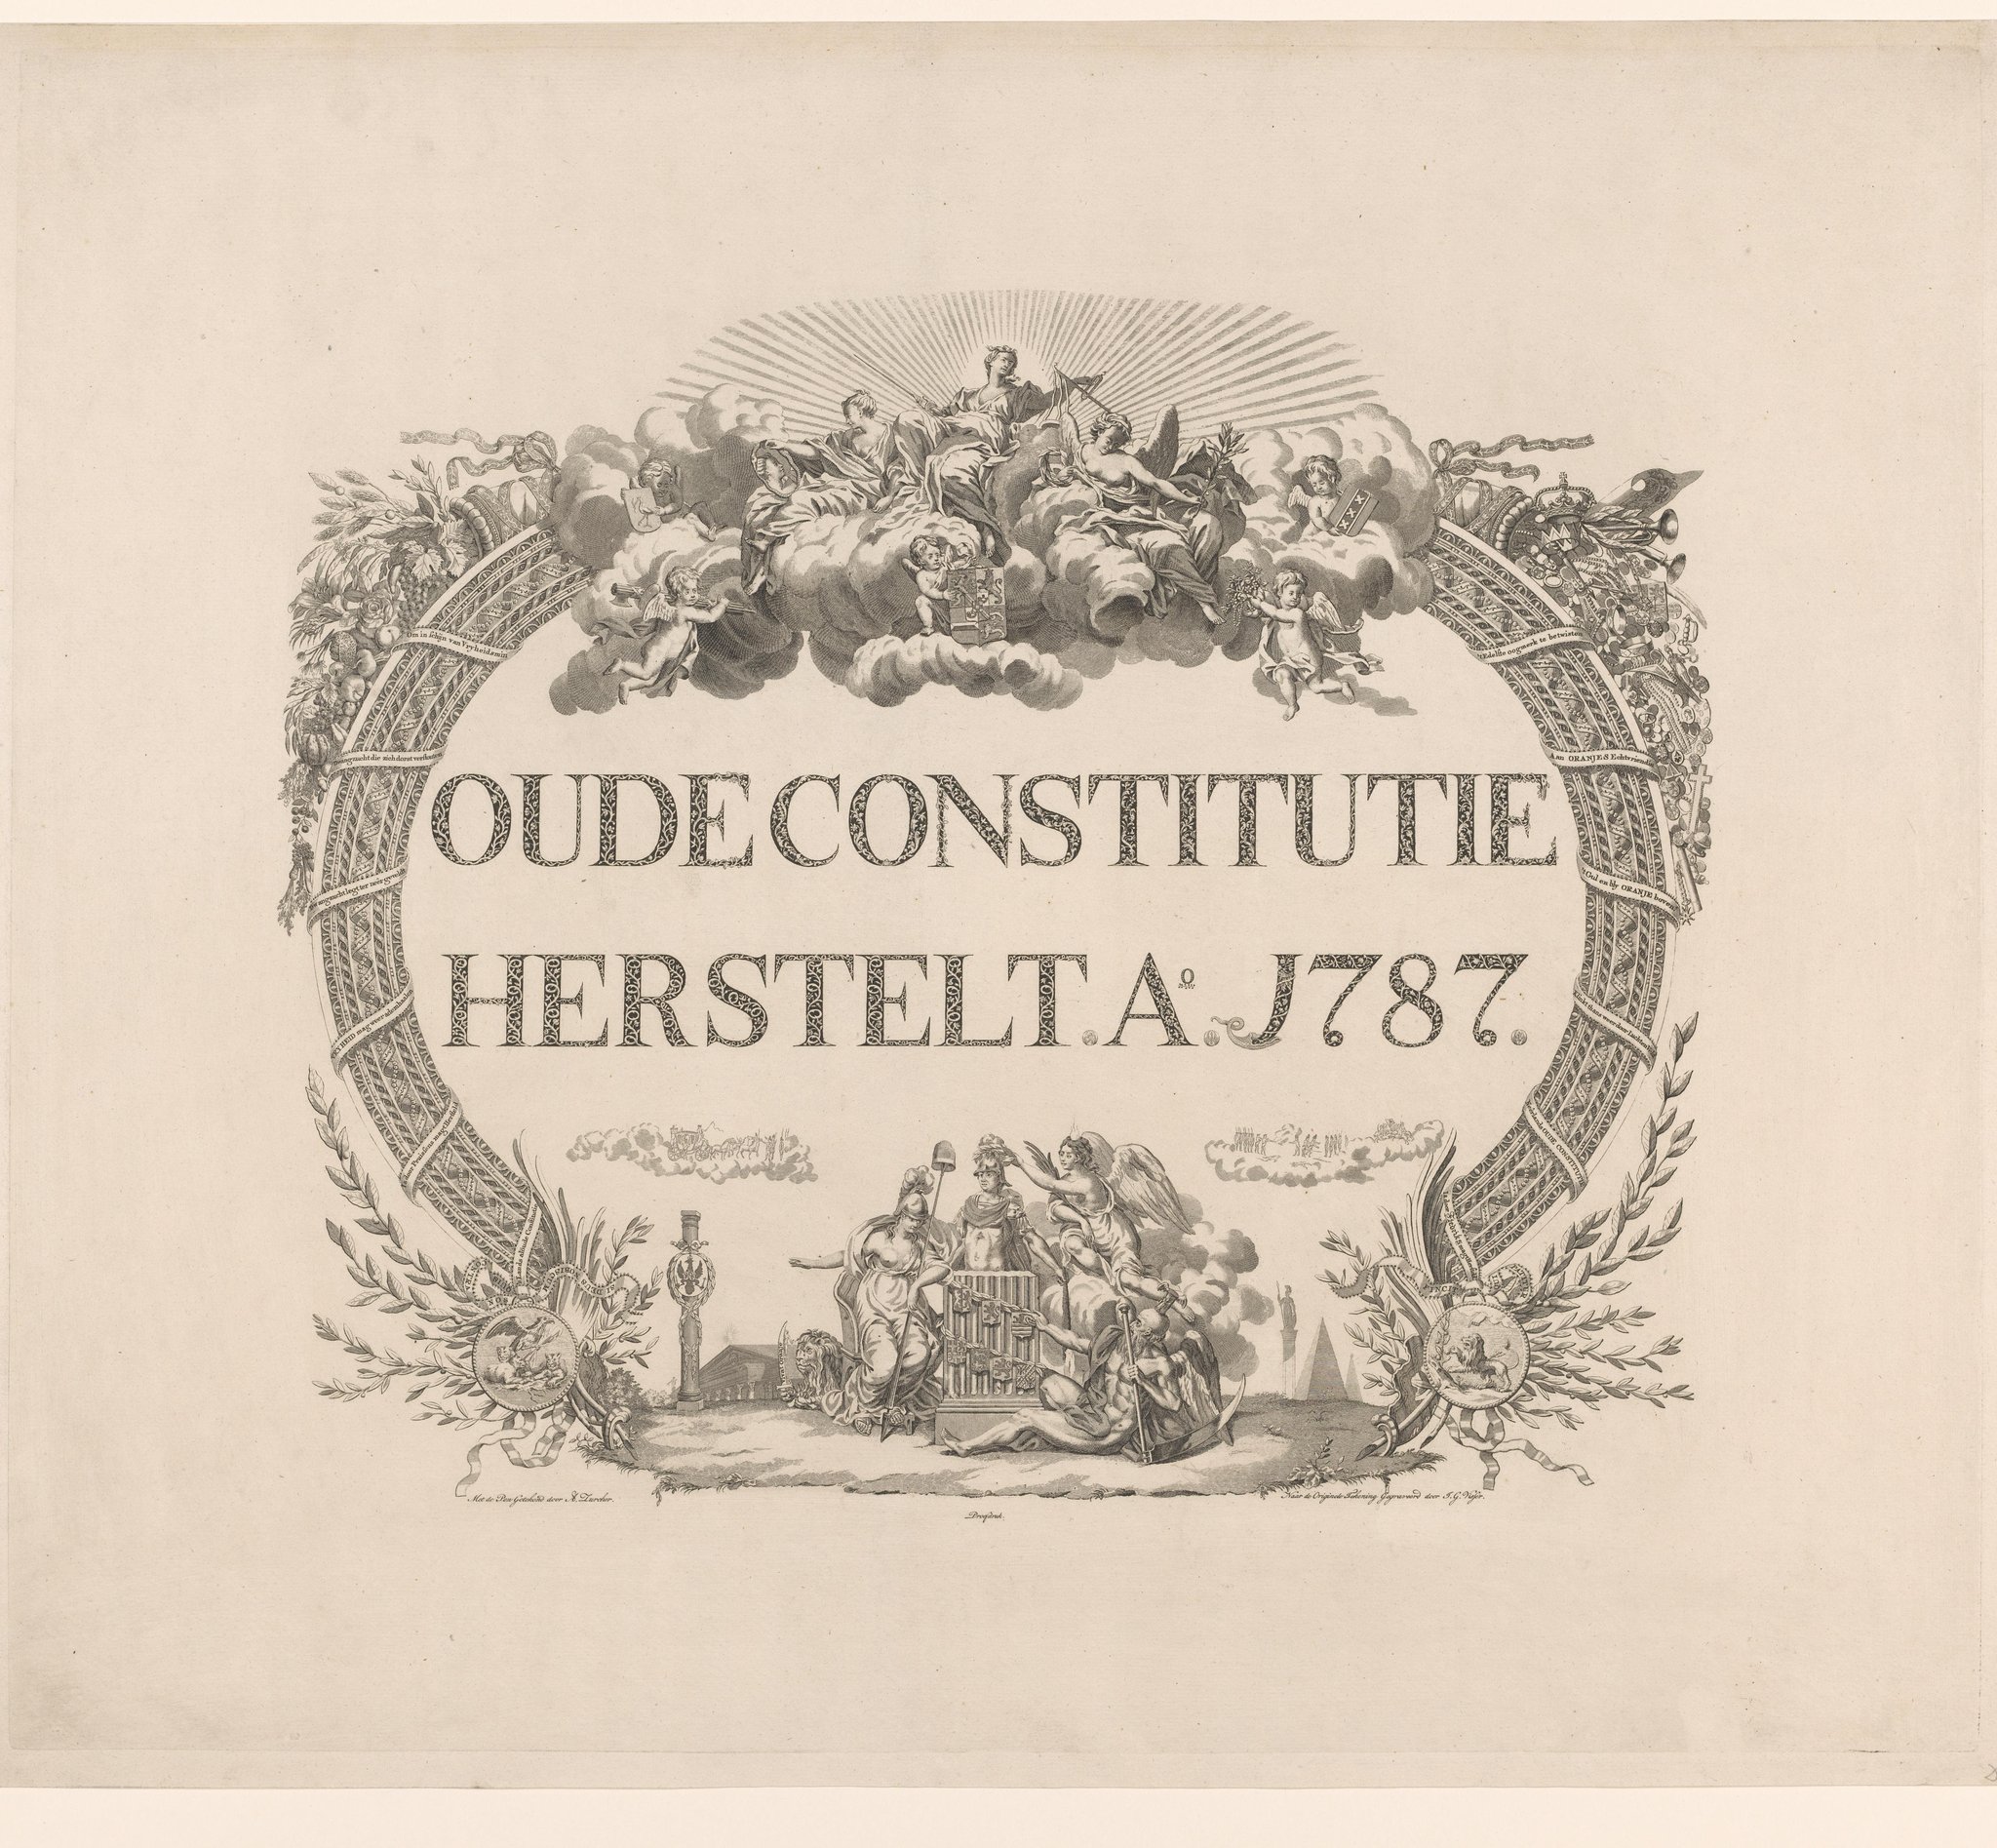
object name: print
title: Oude Constitutie Herstelt Ao 1787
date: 1787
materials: paper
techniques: etching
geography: netherlands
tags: justice, 'justitia'; 'giustitia divina' (ripa) ~ one of the four cardinal virtues, symbols, allegories of peace, 'pax'; 'pace' (ripa), father time, man with wings and scythe, freedom, liberty; 'libertà' (ripa) (+ abstract concept represented by female figure)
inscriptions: collector's mark: Lugt 2228